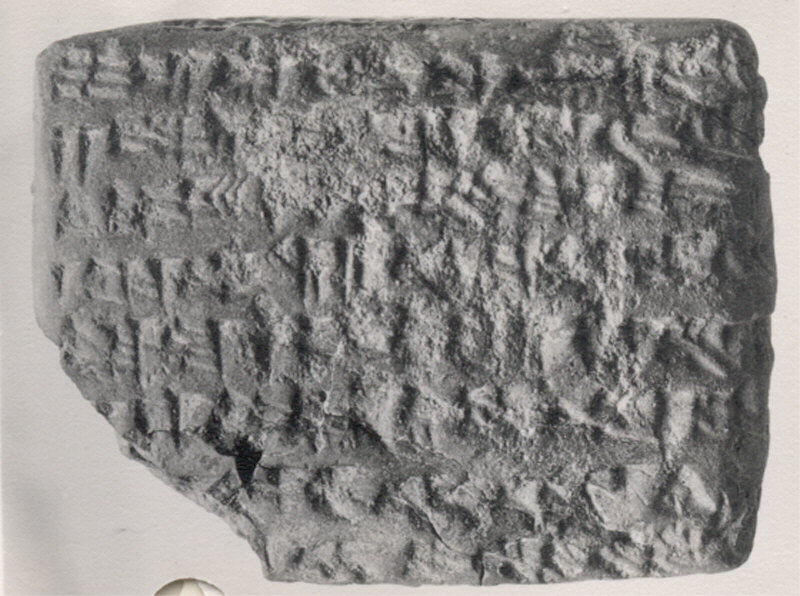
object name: cuneiform tablet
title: Cuneiform tablet: promissory note for cress and barley, Esagilaya archive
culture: babylonian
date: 556 BCE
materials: clay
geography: mesopotamia